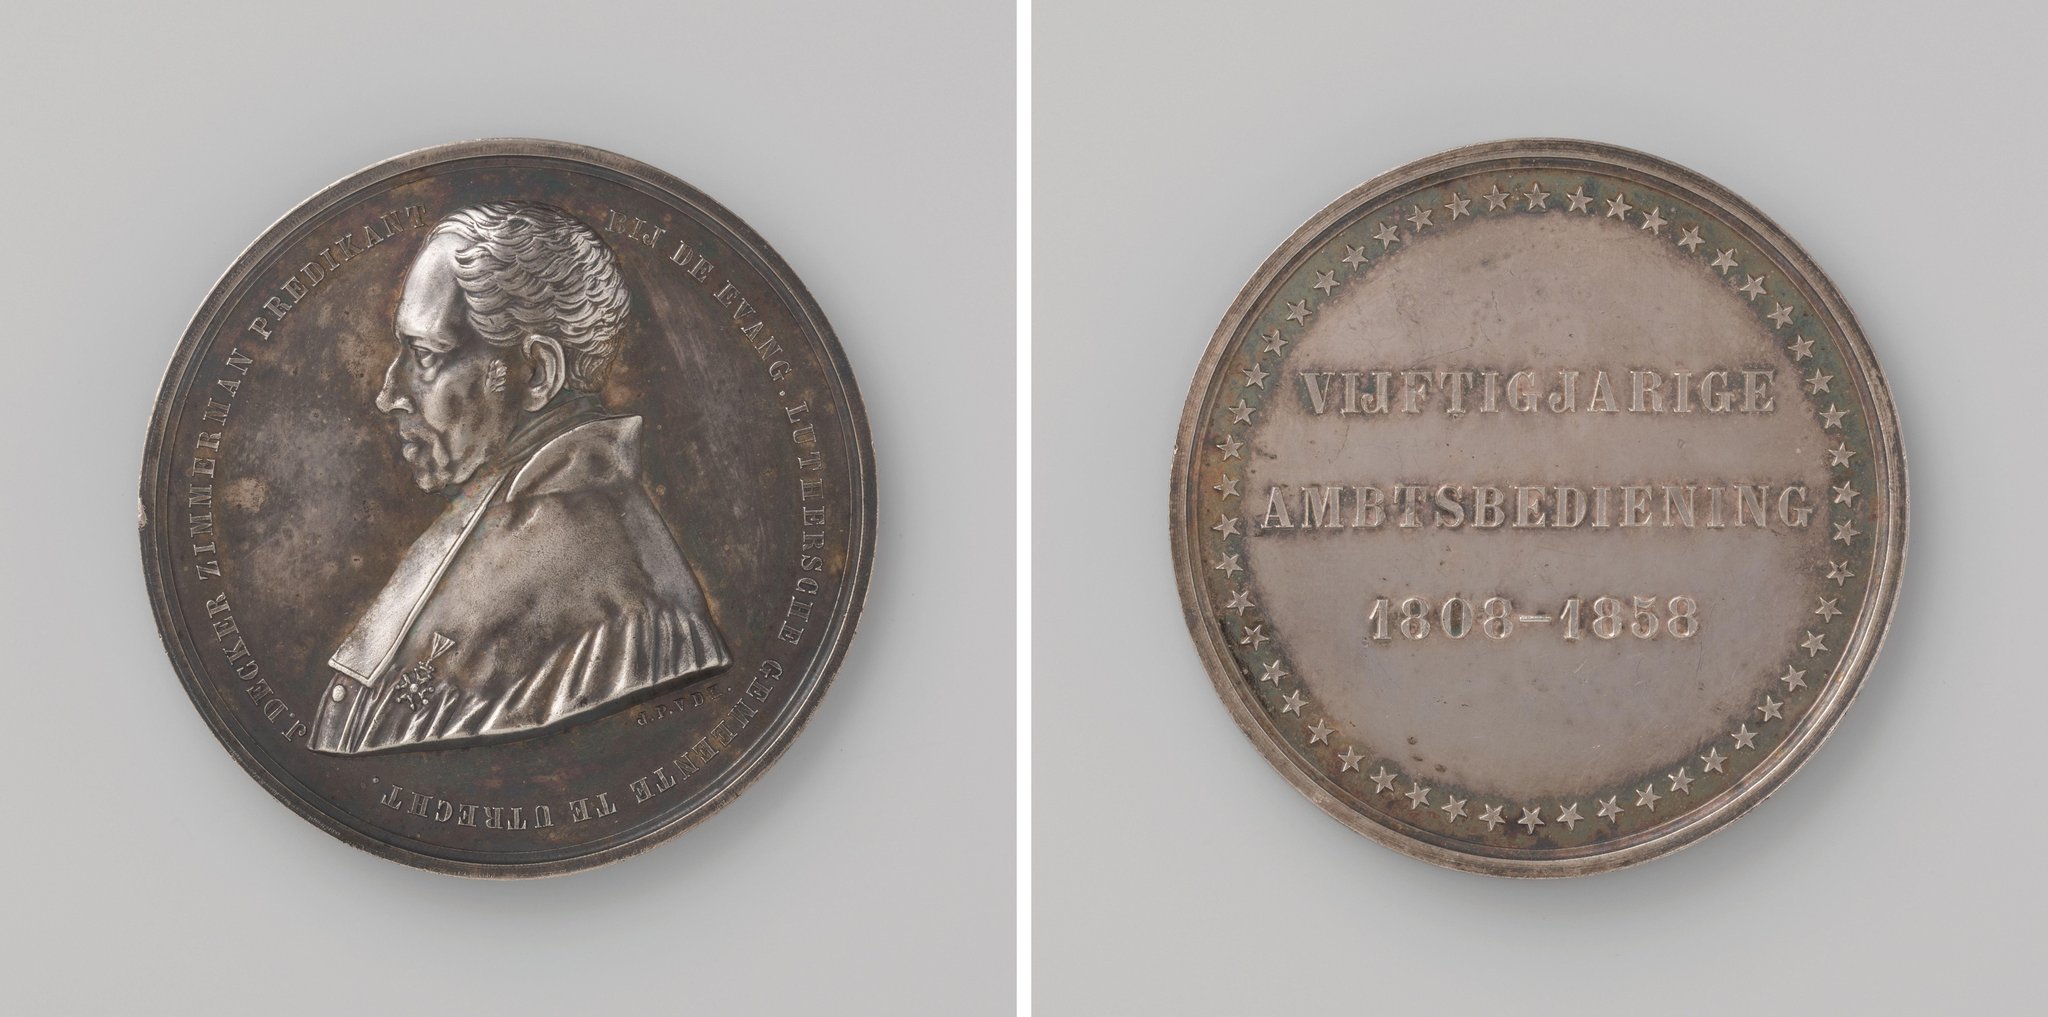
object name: honorary medal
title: Johannes Decker Zimmerman, vijftig jaar predikant bij de Evangelisch Luthersche Gemeente te Utrecht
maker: johan philip van der kellen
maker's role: draughtsman, print maker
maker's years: 1831-1906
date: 1858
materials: silver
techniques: striking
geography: utrecht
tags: utrecht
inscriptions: inscription: ‘VIJFTIGJARIGE/ AMBTSBEDIENING/ 1808-1858’, circumscription: ‘J. DECKER ZIMMERMAN, PREDIKANT BIJ DE EVANG. LUTHERSCHE GEMEENTE TE UTRECHT.’, monogram: ‘J.P.VDK.’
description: Zilveren penning. Voorzijde: borststuk naar links van man binnen omschrift. Keerzijde: opschrift binnen krans van vijftig sterren.